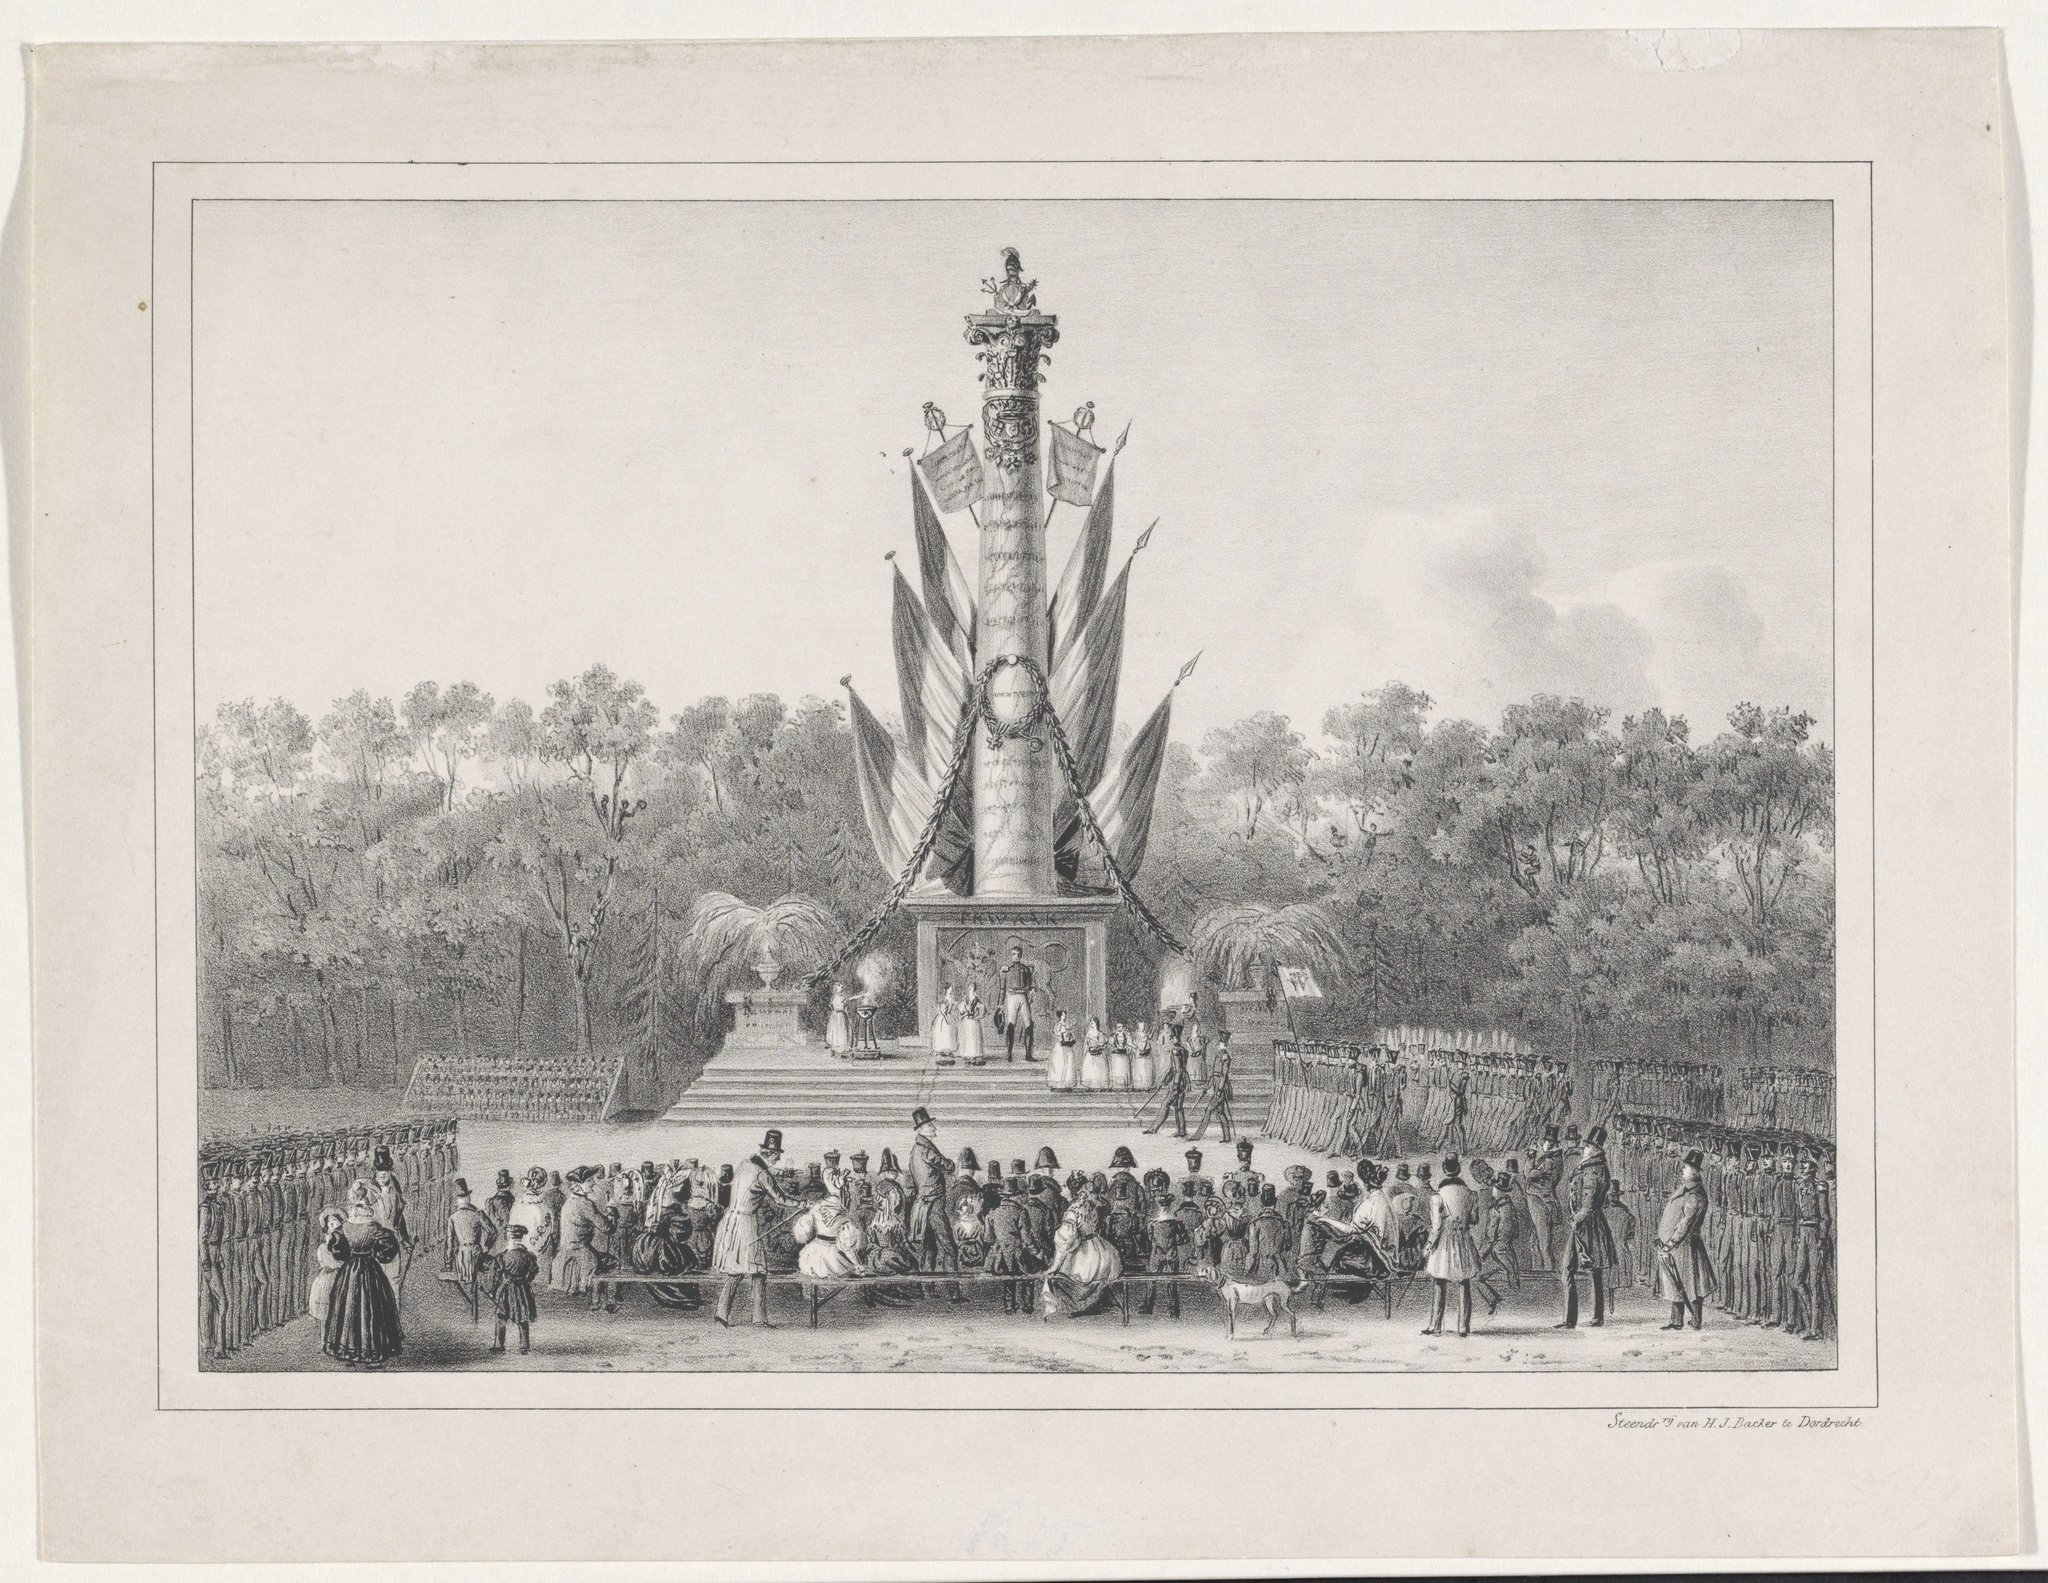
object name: print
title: Ontvangst van de terugkerende Nederlandse krijgsgevangenen in Gorincem, 1833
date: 1833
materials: paper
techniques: lithograph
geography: dordrecht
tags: liberating prisoners of war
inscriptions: collector's mark: Lugt 2228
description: Feestelijke ontvangst in Gorinchem van de Nederlandse militairen die tijdens het beleg en bij de verovering van de Citadel van Antwerpen krijgsgevangen zijn genomen en in Sint Omer in gevangenschap zaten, 22-23 juni 1833. Gezicht op het Exercitieveld bij de Kanselpoort waar een zuil met opschrift 'Ik Waak' is opgericht. Rechts defileren de teruggekeerde Nederlandse militairen, voor de zuil de plaatscommandant van Gorinchem, generaal-majoor Muller.